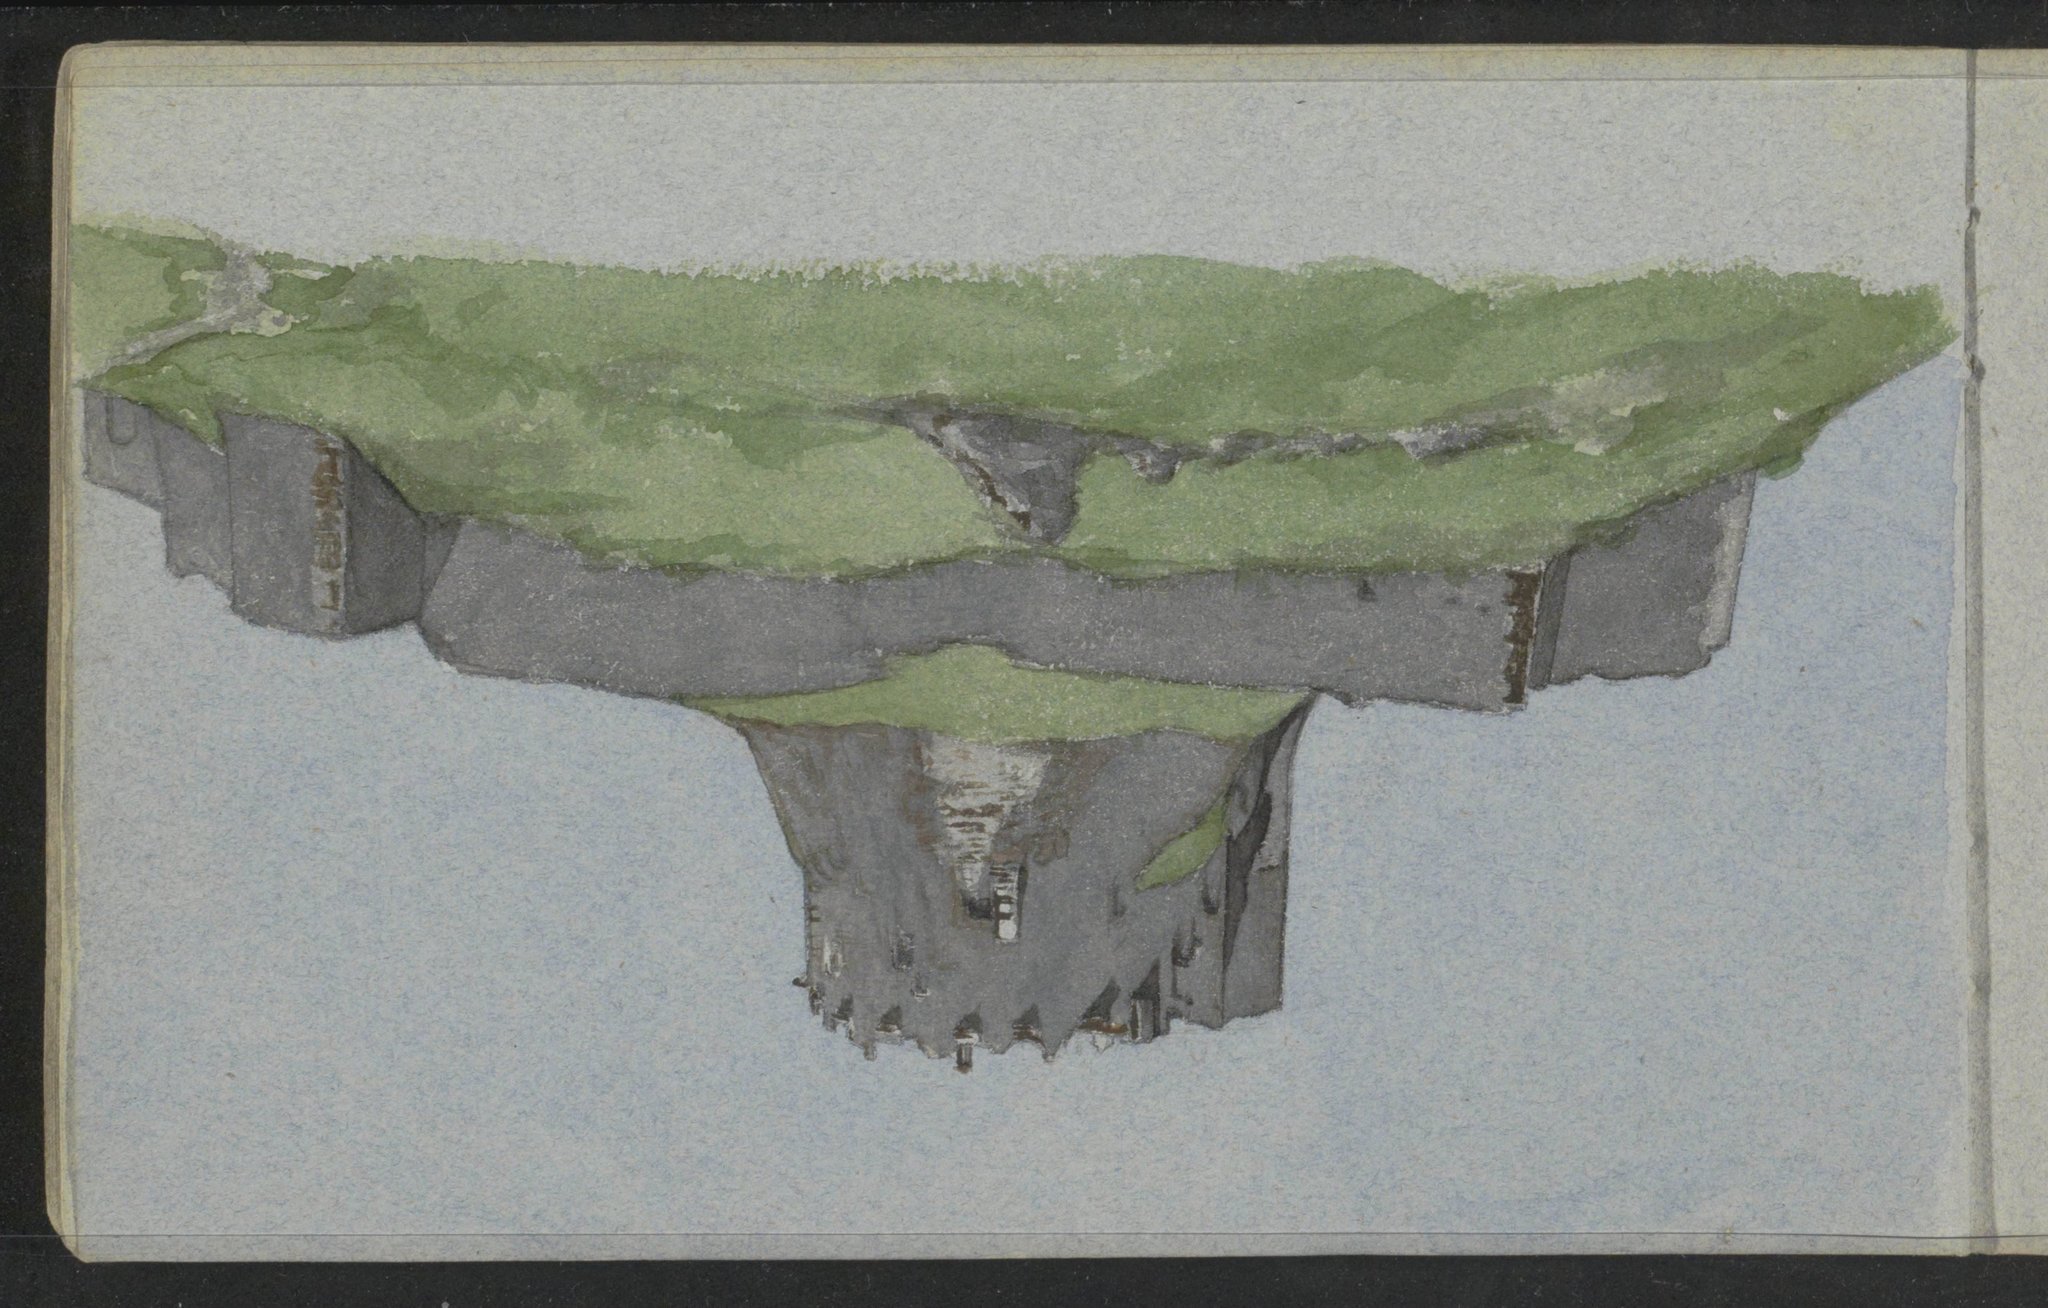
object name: sketchbook leaf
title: Heuvel met een ruïne van een verdedigingstoren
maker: matthijs maris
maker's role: draughtsman, painter, print maker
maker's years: 1839-1917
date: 1849-1917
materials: paper, pencil, watercolor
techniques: brush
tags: ruin of a building ~ architecture, towers ~ fortified city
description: Blad 29 verso uit een schetsboek met 35 bladen.